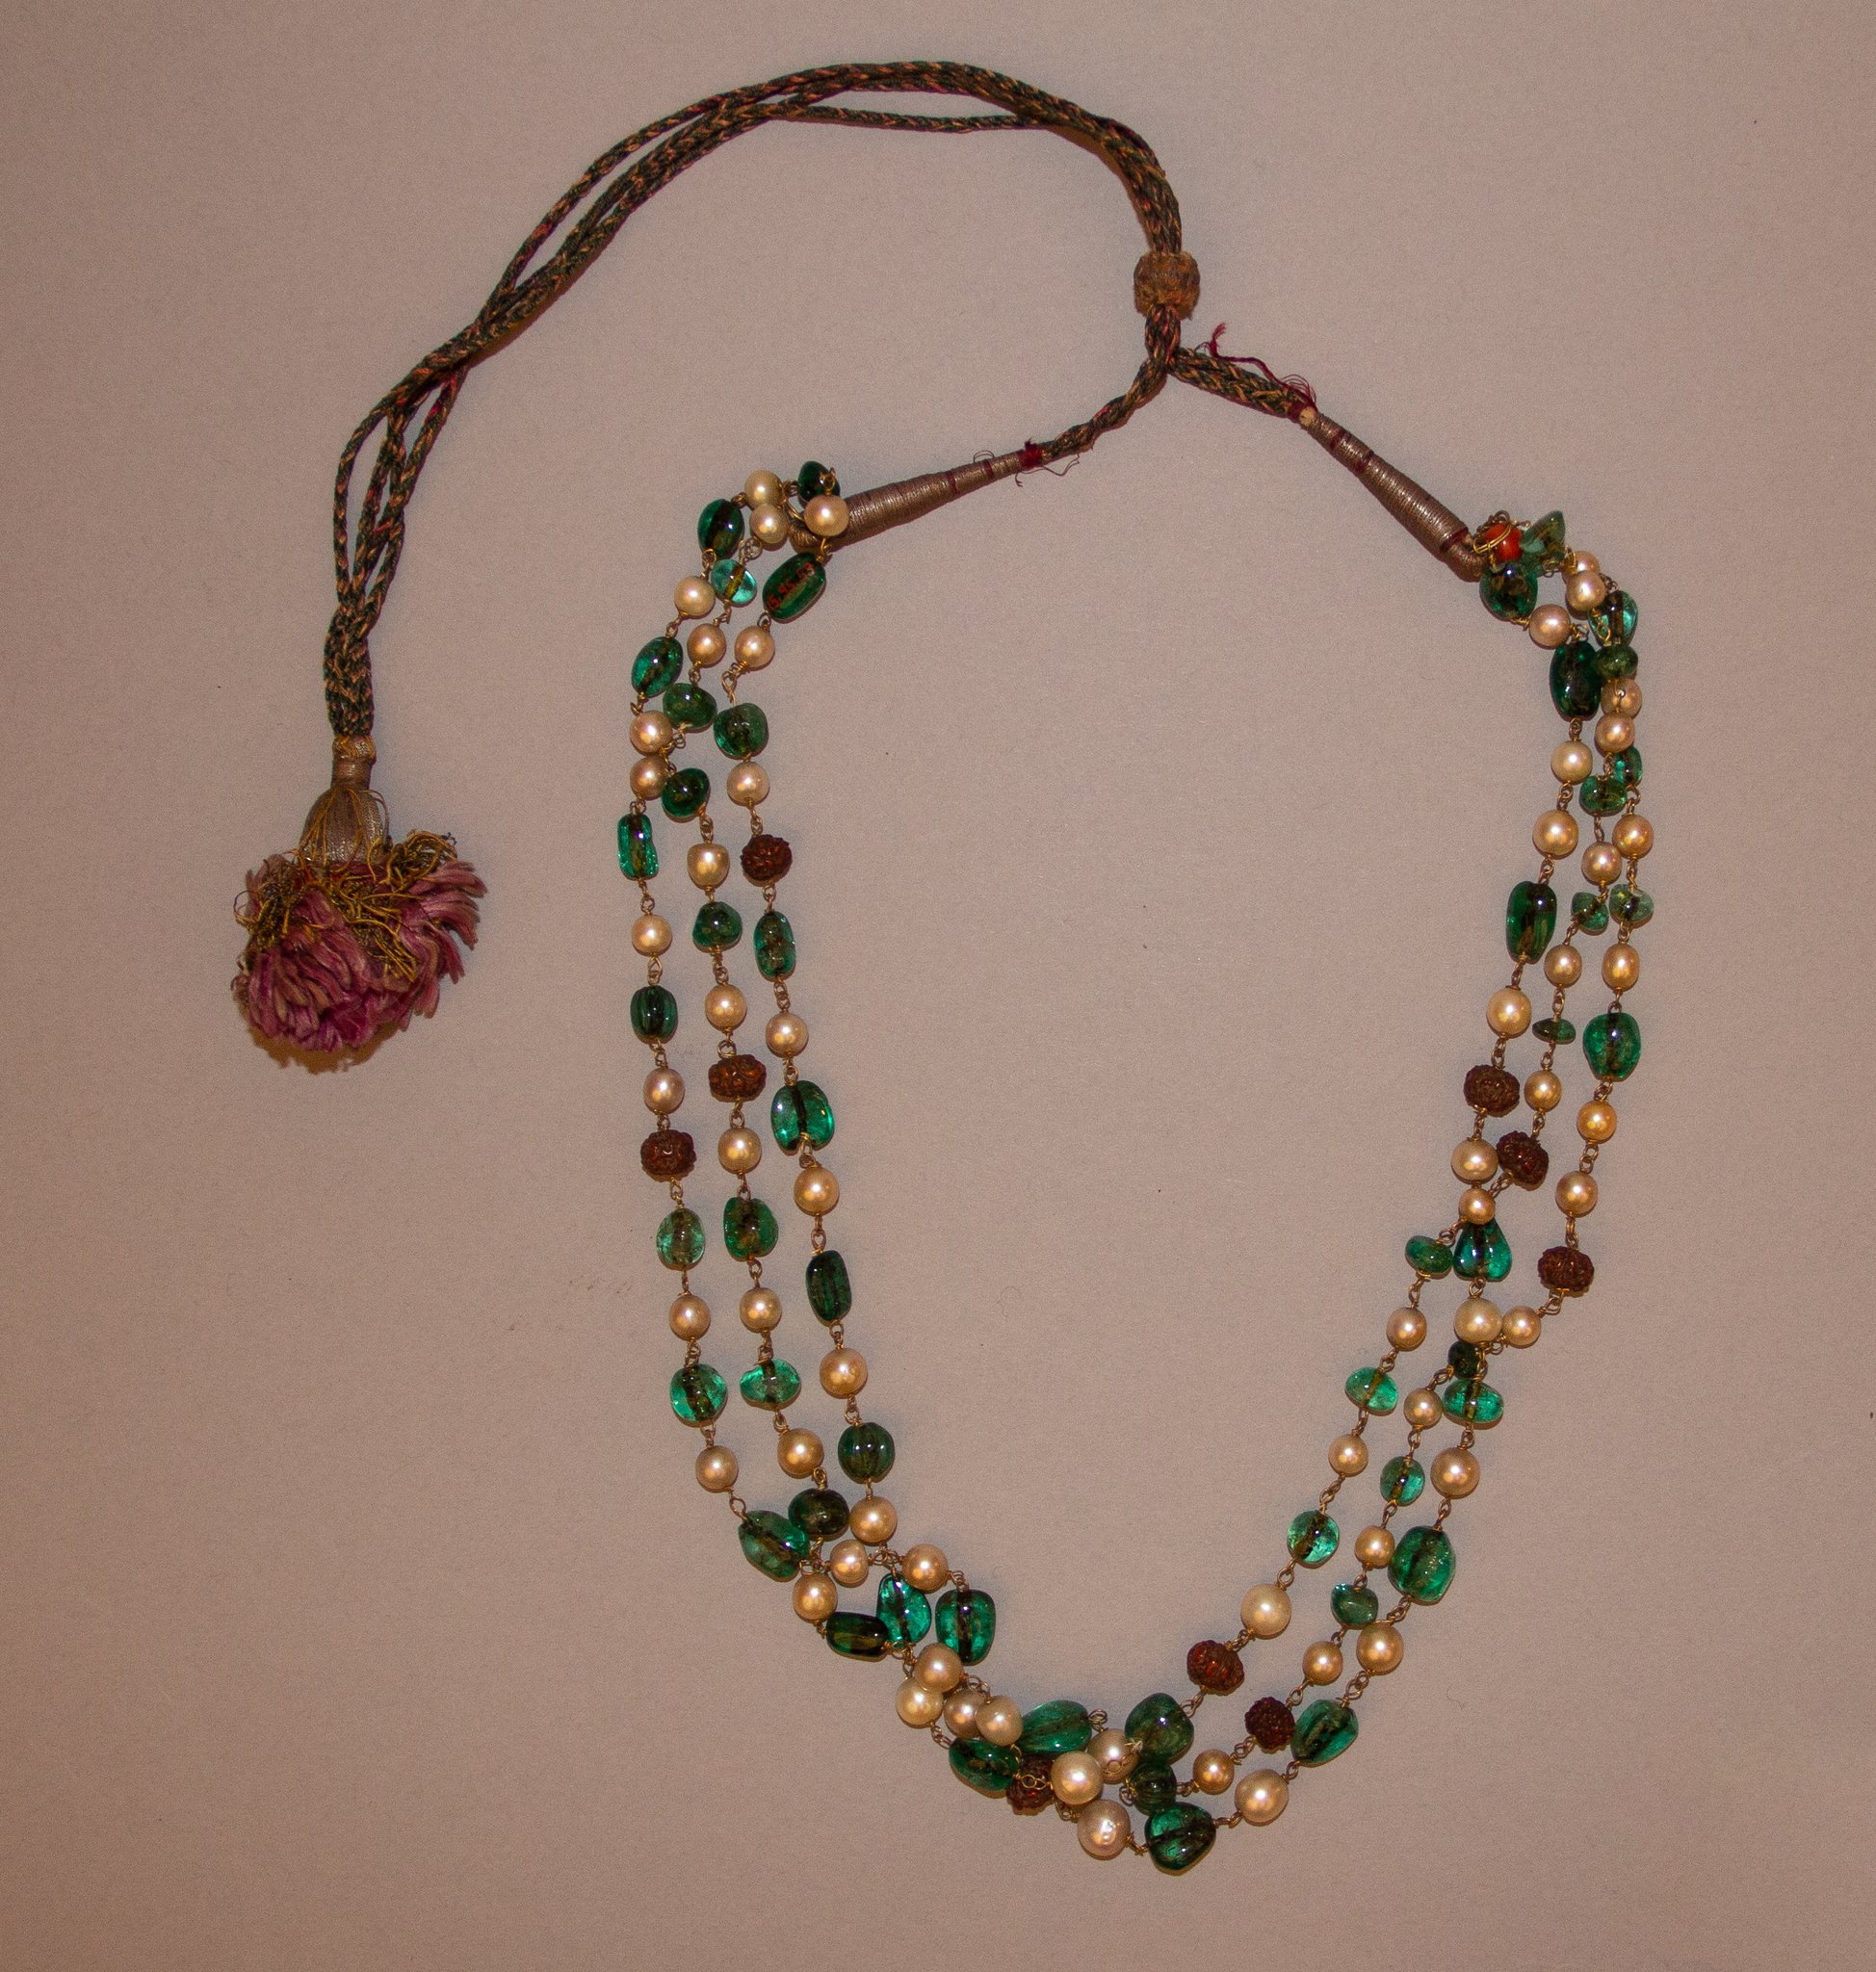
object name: necklace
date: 1601-1900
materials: gemstone, gold, pearl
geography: india